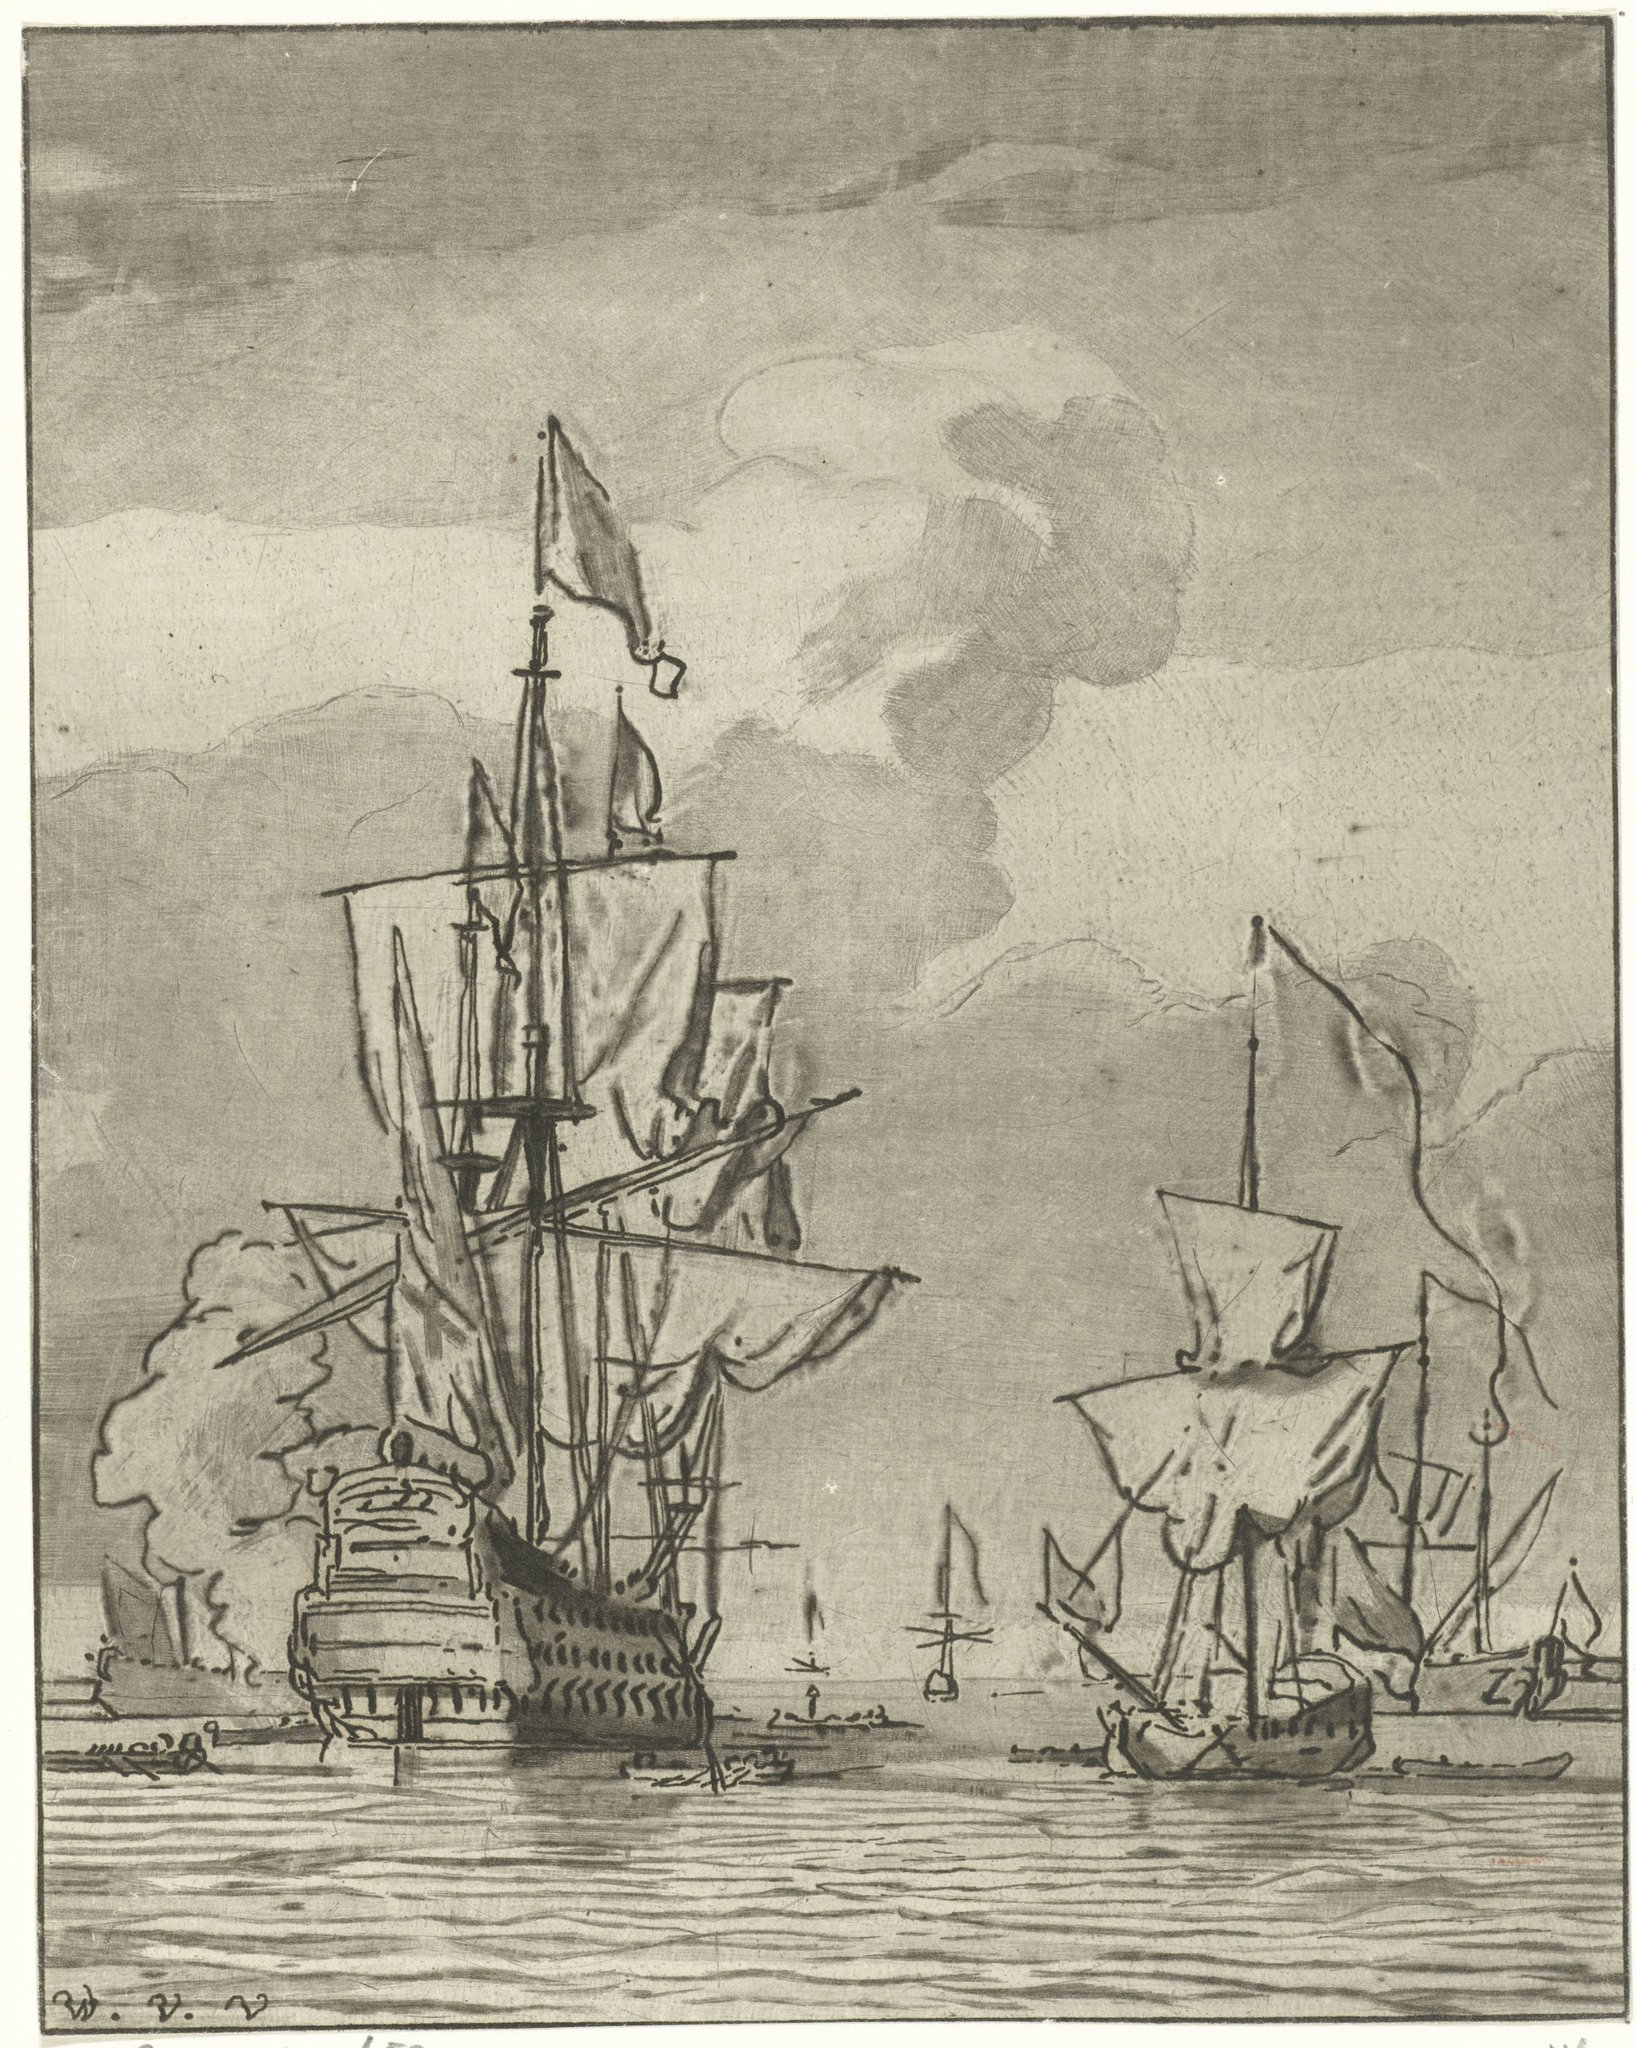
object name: print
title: Oorlogsschip een schot lossend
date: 1821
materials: paper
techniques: etching, roulette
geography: amsterdam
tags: sailing-ship, sailing-boat, cannon shots (military salute)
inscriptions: collector's mark: Lugt 2725, collector's mark: Lugt 12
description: Verschillende zeilschepen op zee, waarvan één een schot lost.